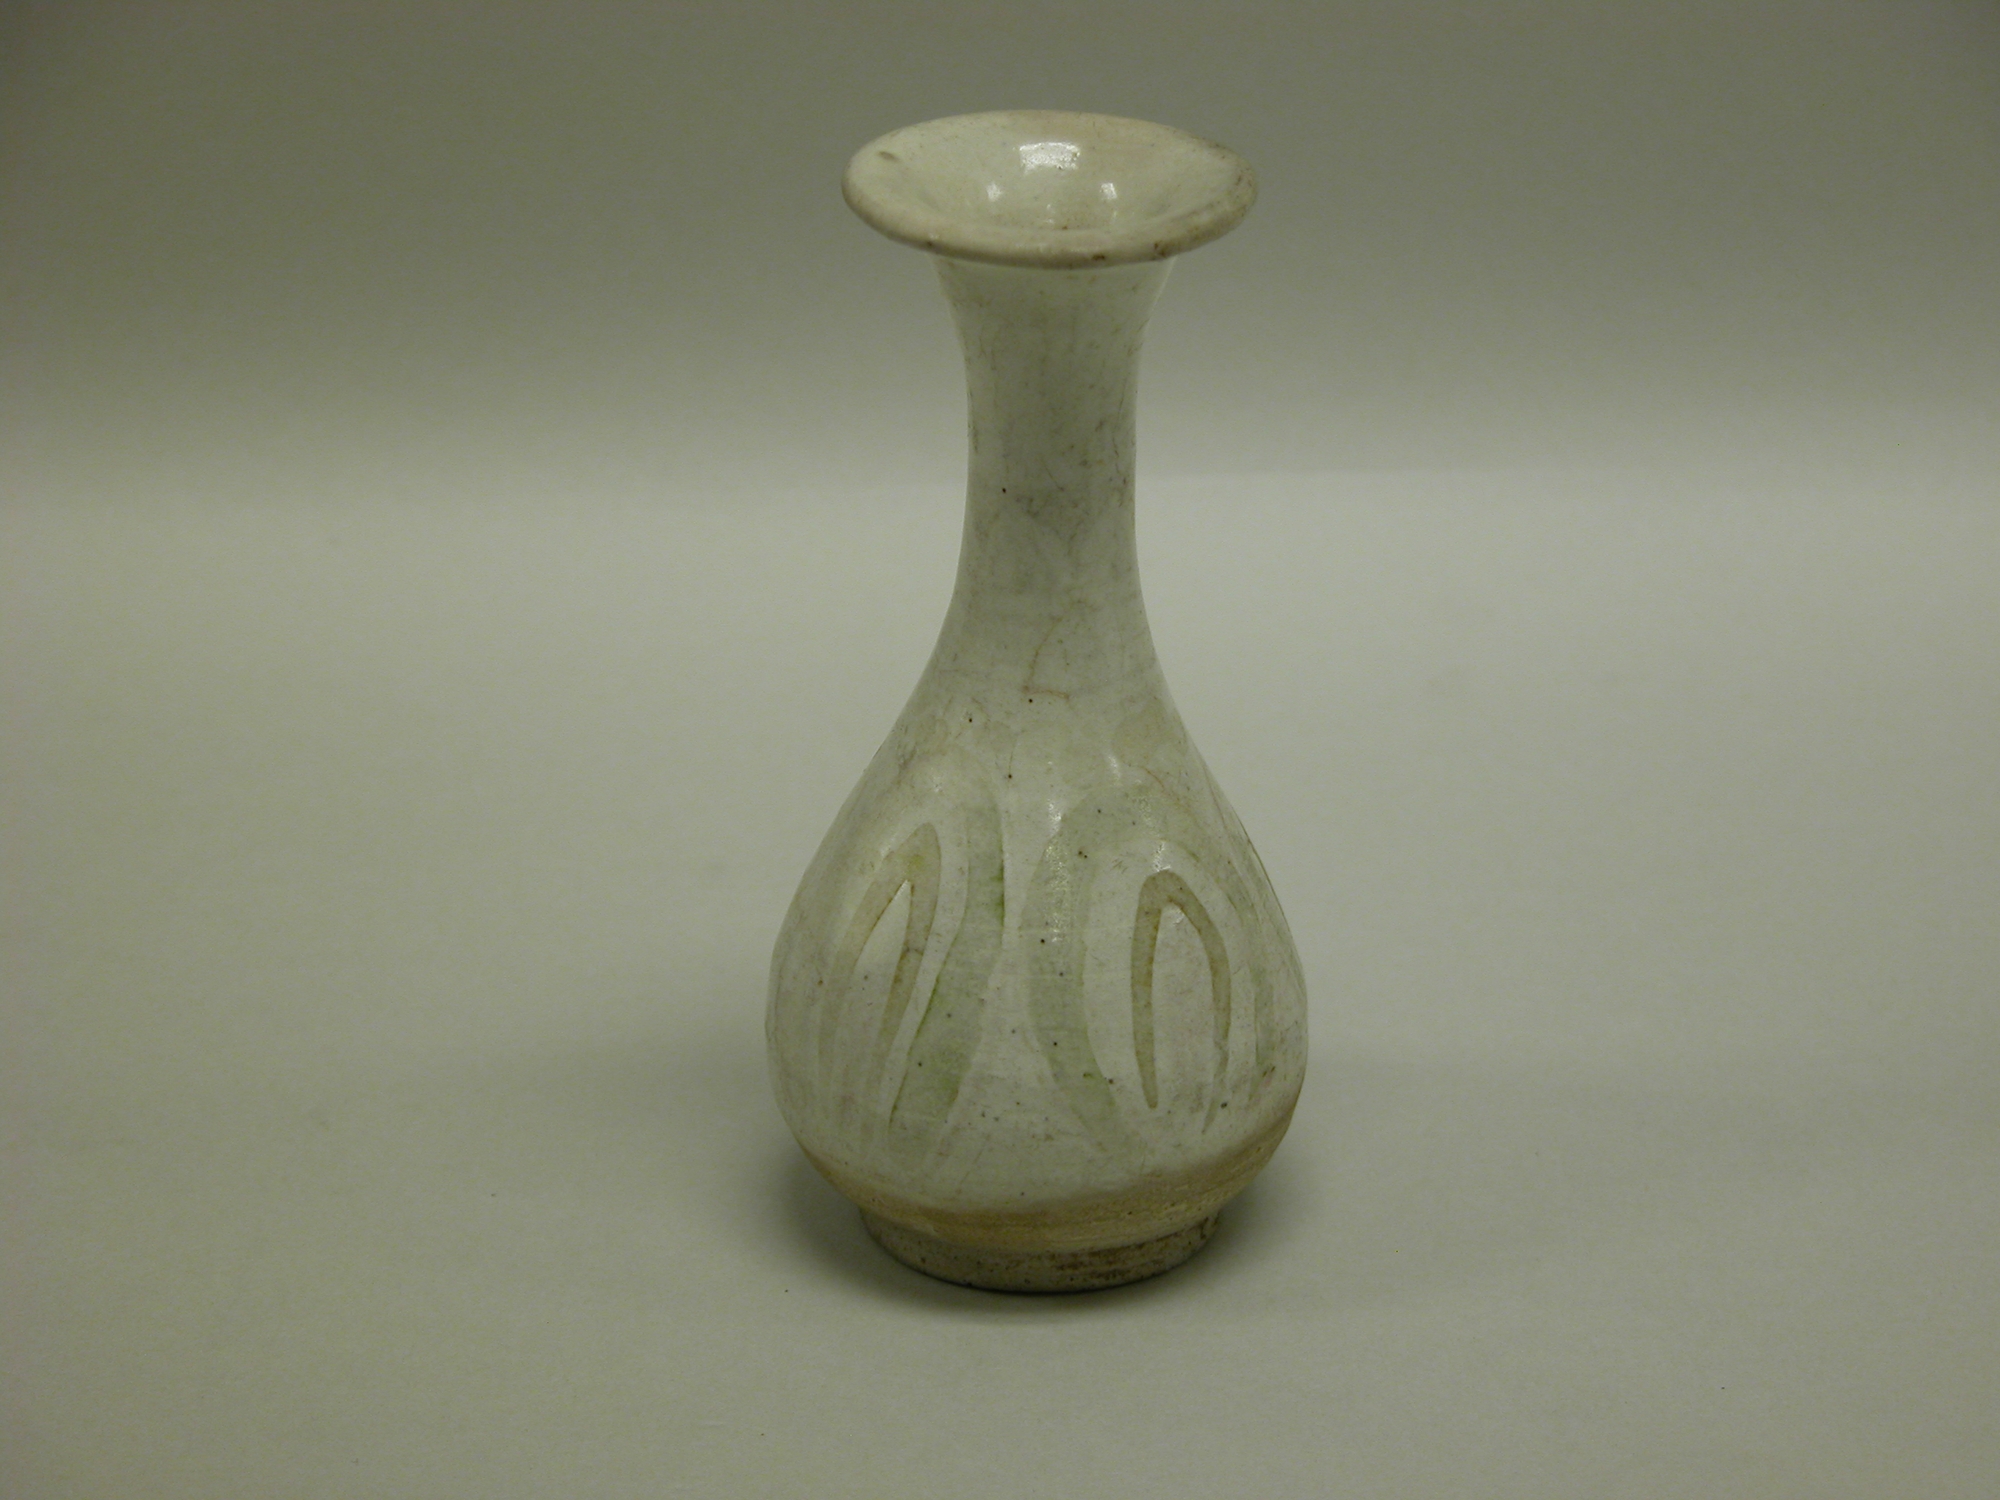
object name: vase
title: Yuhuchun vase with lotus petals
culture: chinese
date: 1201-1400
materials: stoneware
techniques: incising